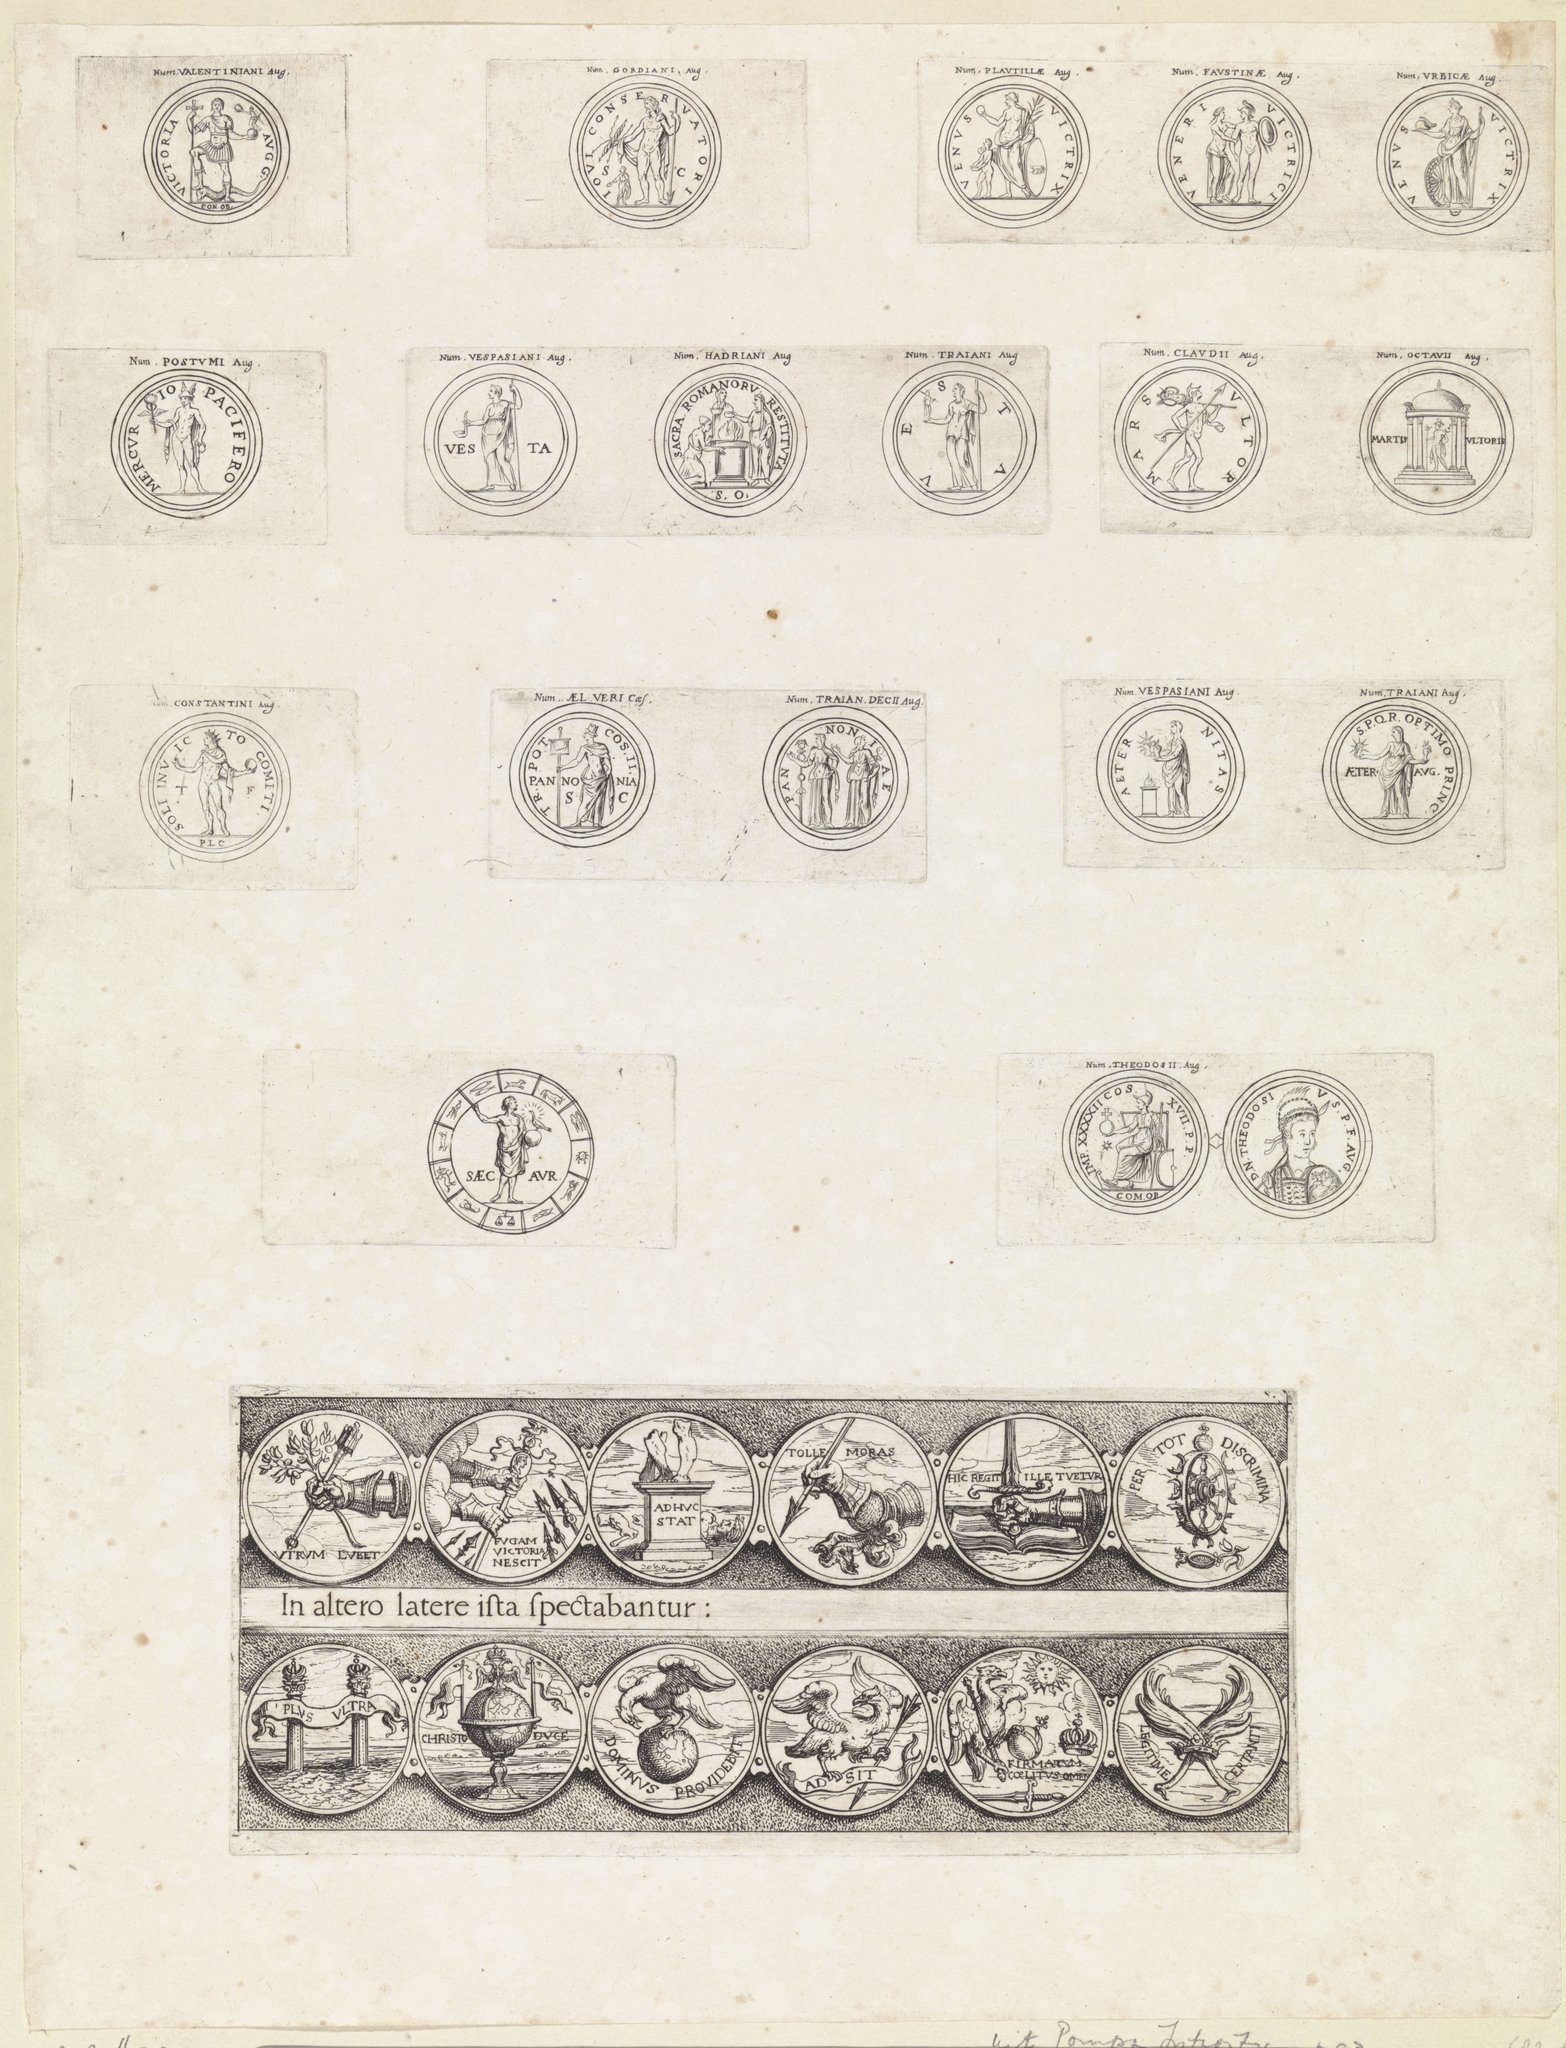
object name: print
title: Negentien Romeinse munten met deviezen en emblemen van keizers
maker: theodoor van thulden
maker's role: draughtsman, painter, print maker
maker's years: 1606-1669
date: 1642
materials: paper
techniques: engraving, etching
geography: antwerp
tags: coin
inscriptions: collector's mark: Lugt 240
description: Prenten gebruikt in: Gevartius, Casper. Pompa introitvs (...) Ferdinandi Avstriaci (...) a S. P. Q. Antverp. decreta et adornata; (...) cùm (...) Antverpiam auspicatissimo aduentu suo bearet, XV. kal. maii, ann. M.DC.XXXV. Antwerpen: Jan van Meurs, 1642.